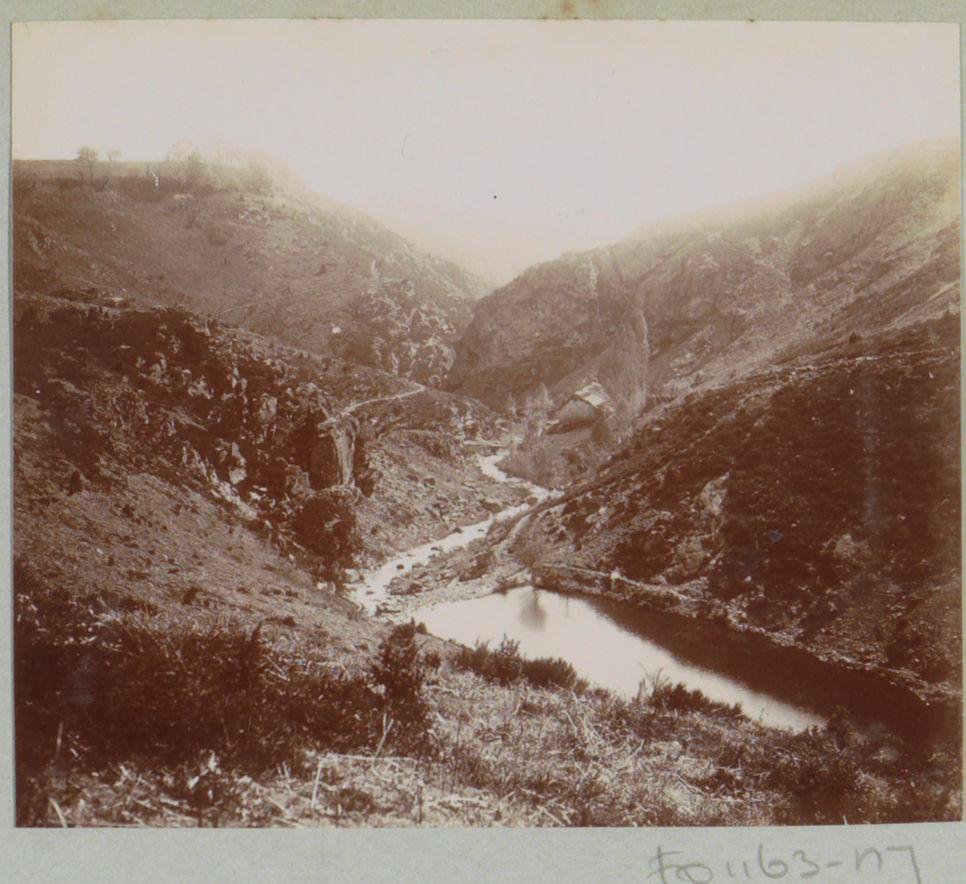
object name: photograph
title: Gezicht op een dal met weg, huis en water, vermoedelijk in de Auvergne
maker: delizy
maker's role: manufacturer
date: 1902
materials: paper, photographic support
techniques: gelatin silver print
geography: volvic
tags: dale, valley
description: Onderdeel van Fotoalbum van een Franse amateurfotograaf met opnames van uitstapjes in Frankrijk, Spanje, België, Luxemburg en Nederland, de eerste automobielen en autoraces.